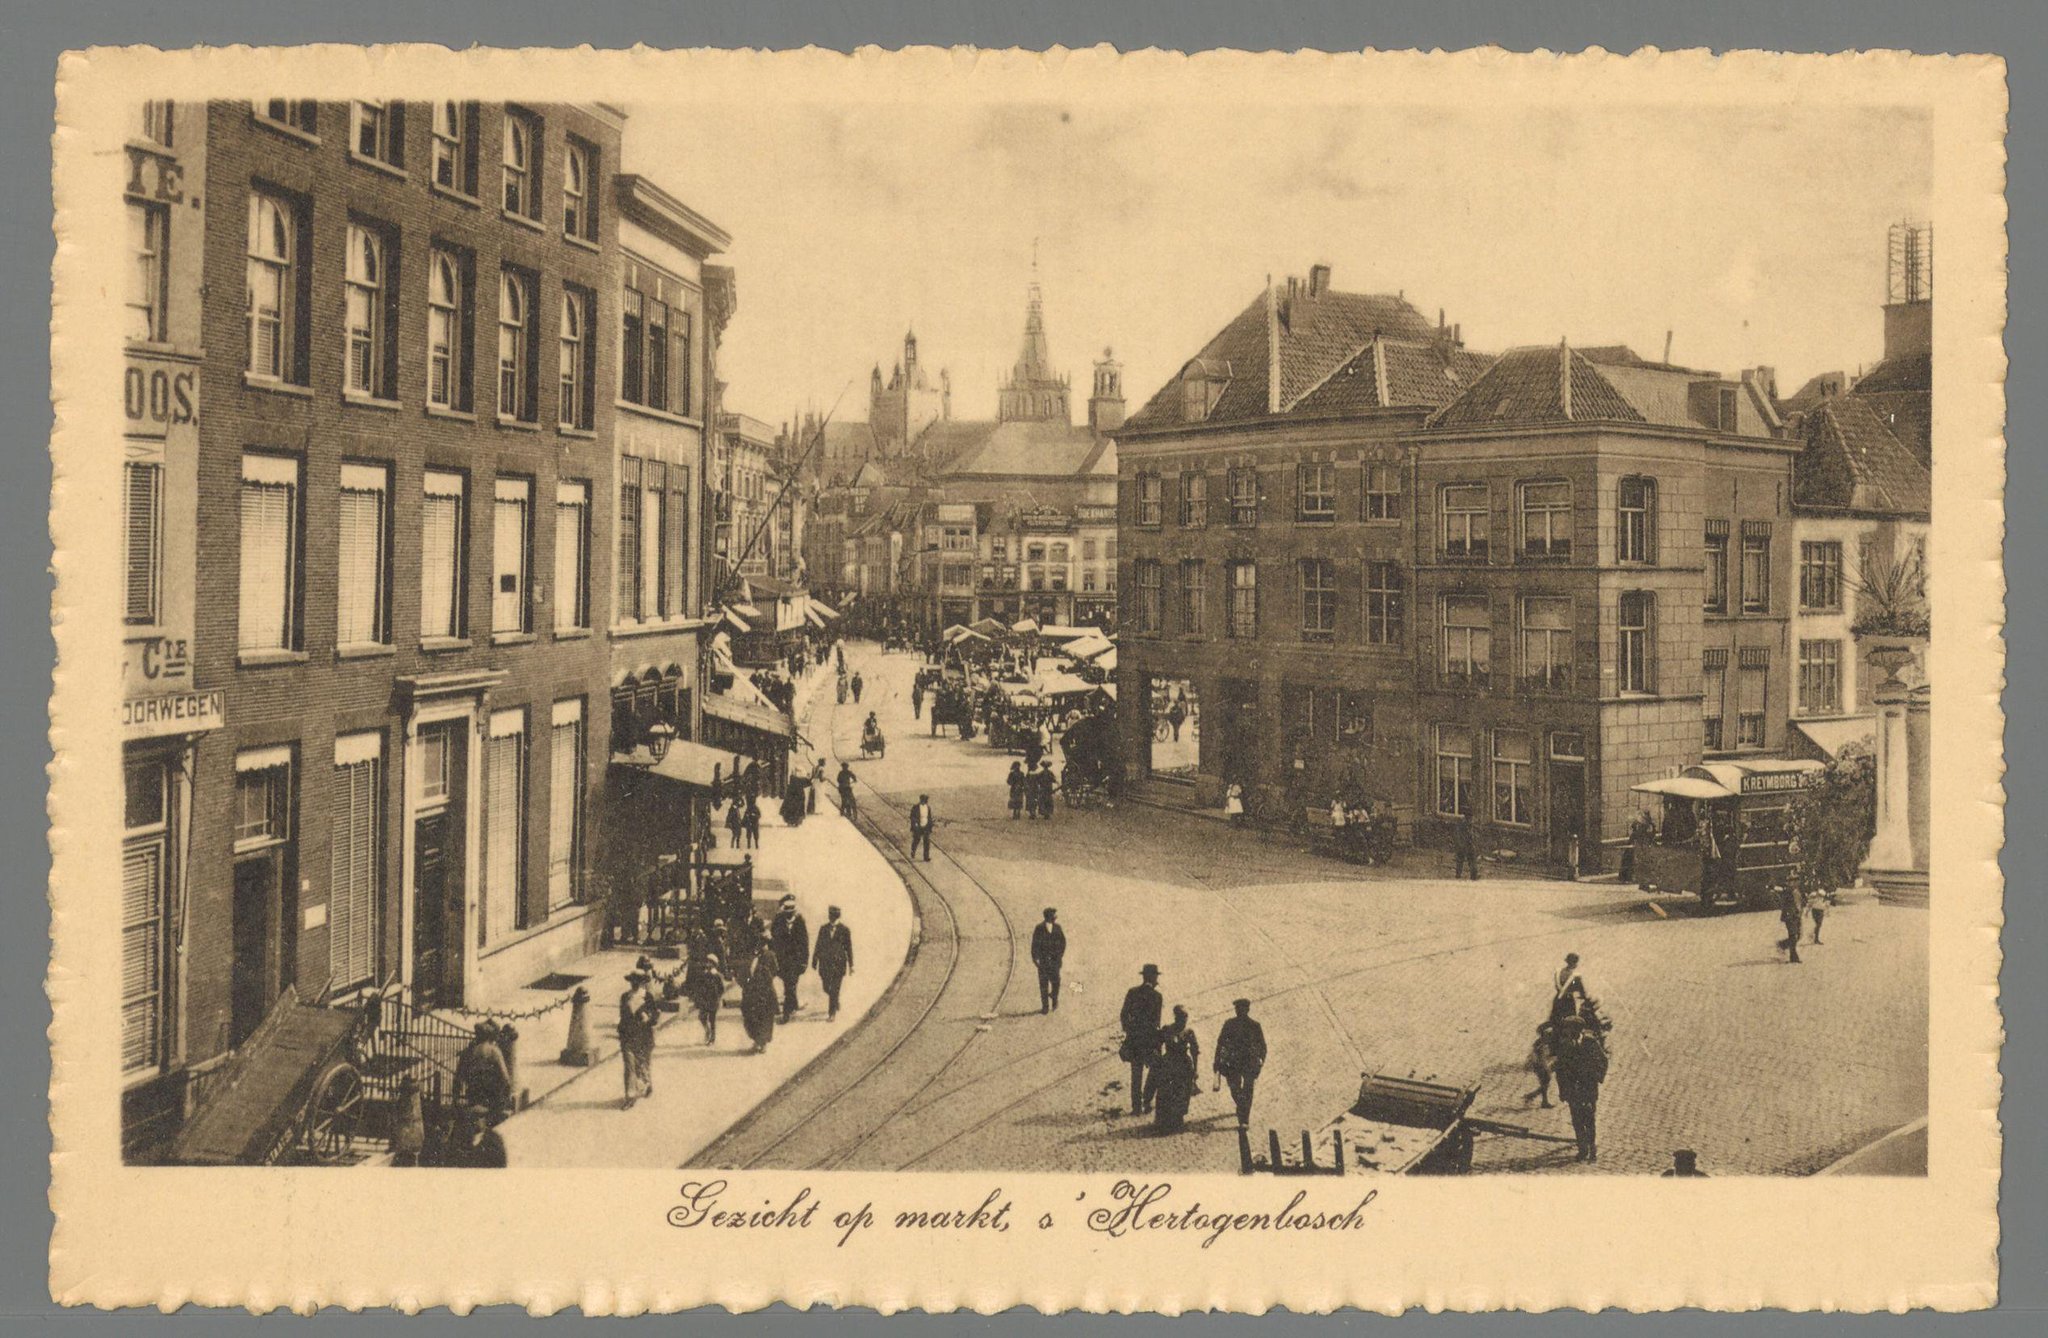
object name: ansichtkaart, prentbriefkaart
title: Gezicht op markt, s'Hertogenbosch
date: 1913-1930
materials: cardboard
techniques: photograph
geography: rotterdam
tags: city-view, and landscape with man-made constructions, market